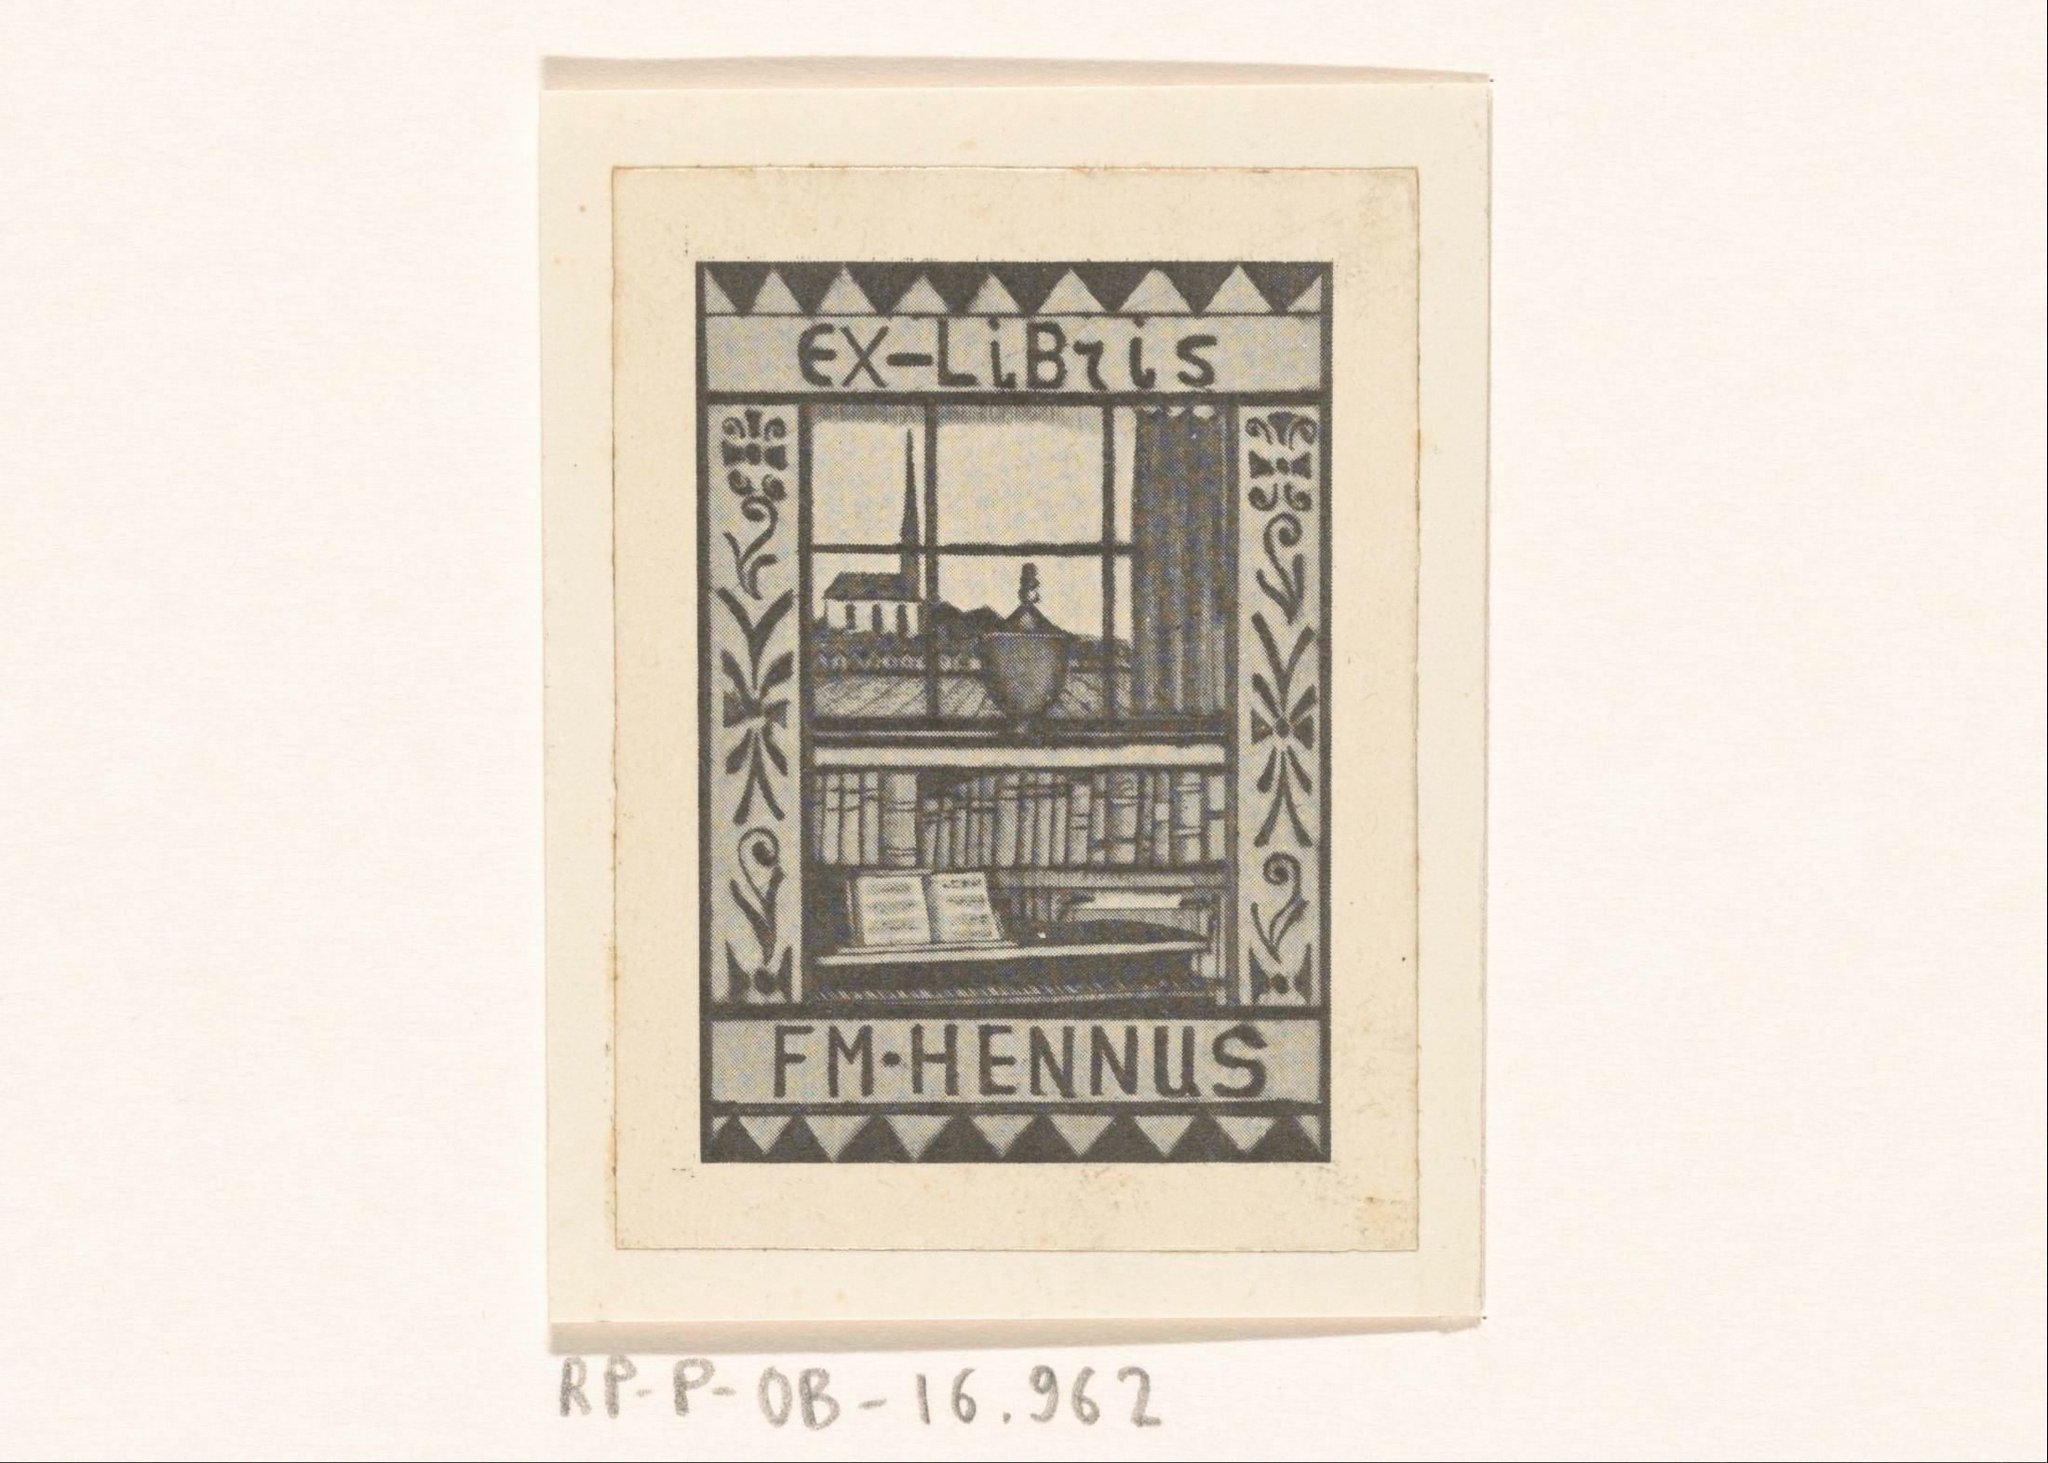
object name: print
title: Ex libris van Michiel Frederik Hennus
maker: lodewijk schelfhout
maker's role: draughtsman, print maker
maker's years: 1881-1943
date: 1919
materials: paper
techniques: autotype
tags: michiel frederik hennus, church (exterior), view through a window from the inside, book, pianoforte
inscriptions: collector's mark: Lugt 2228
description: Een interieur met een piano en een boekenplank. Door een venster zicht op een kerk.